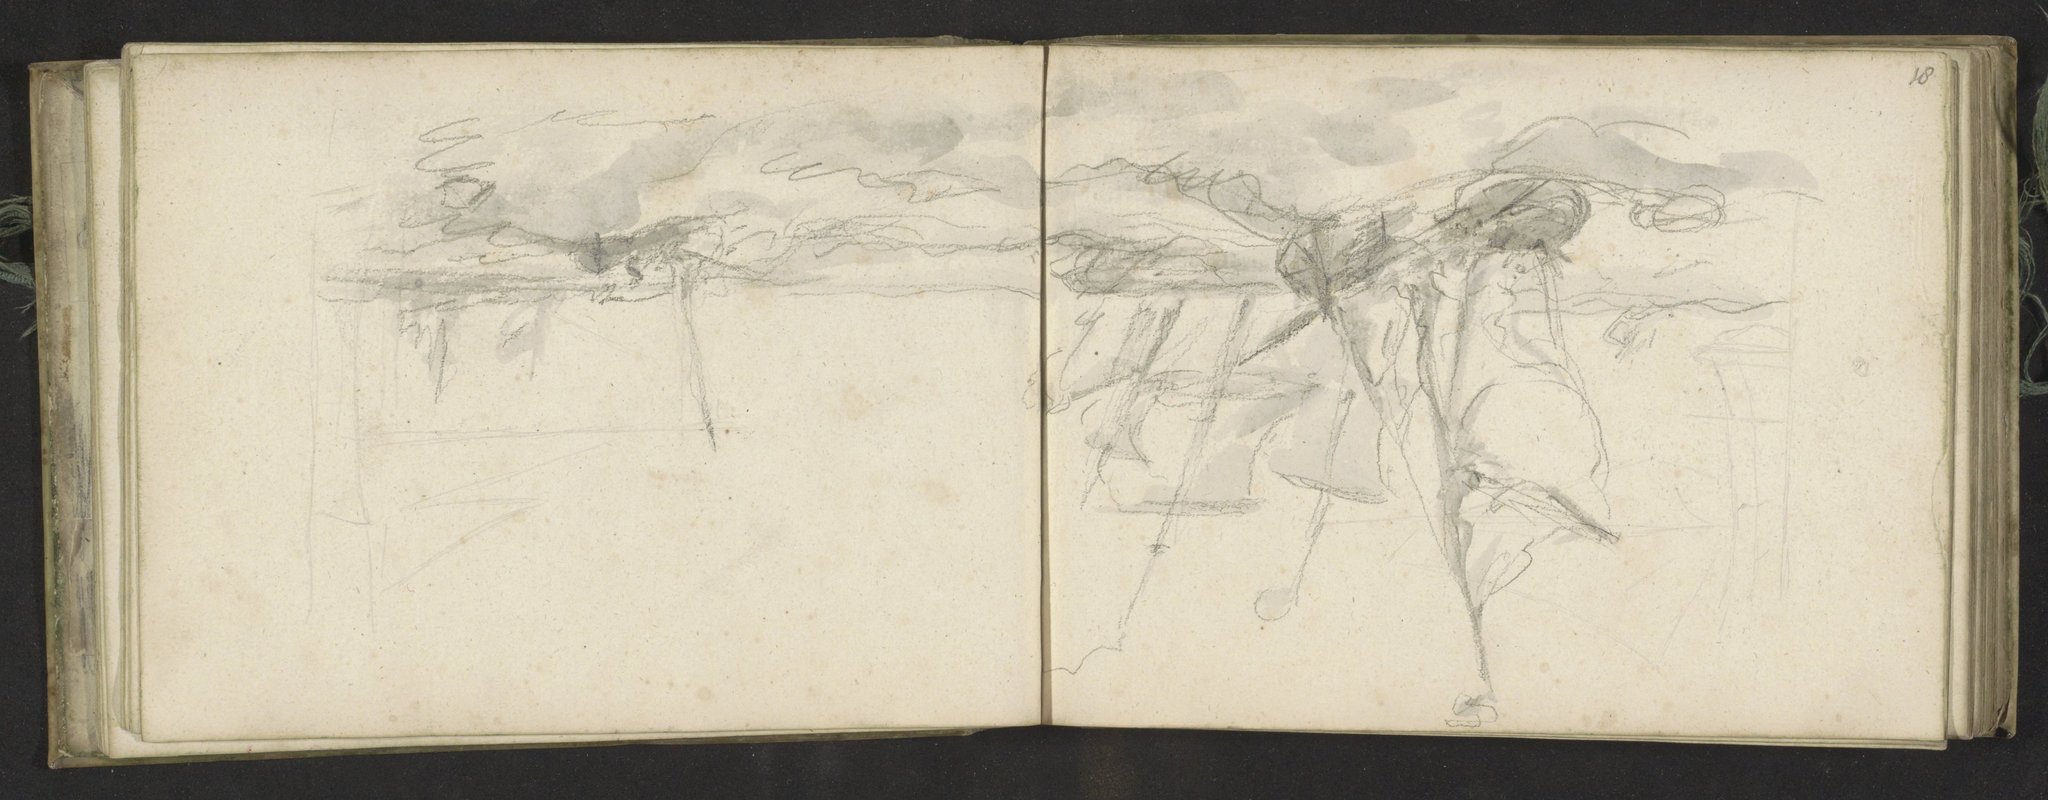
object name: sketchbook leaf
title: Zeilschepen op een woelige zee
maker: martinus schouman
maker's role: draughtsman, painter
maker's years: 1770-1848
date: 1780-1848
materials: paper, pencil, watercolor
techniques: brush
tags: sailing-ship, sailing-boat, storm at sea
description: Blad 17 verso en 18 recto uit een schetsboek met 53 bladen.